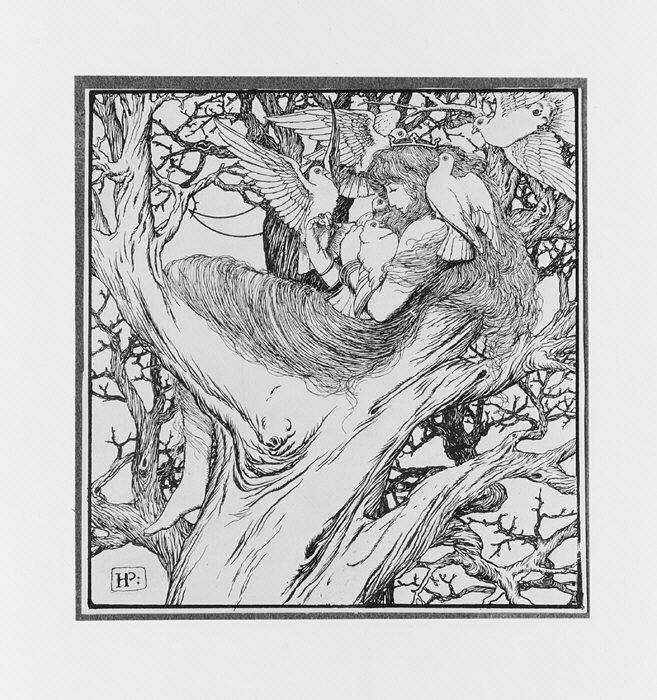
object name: drawing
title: The Princess Dwells in the Oak Tree Where ye Wild Pigeons Come to Feed Her, for "The Wonder Clock"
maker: howard pyle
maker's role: artist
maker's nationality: american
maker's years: 1853-1911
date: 1887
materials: board, graphite, ink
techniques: pen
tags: women,pigeons